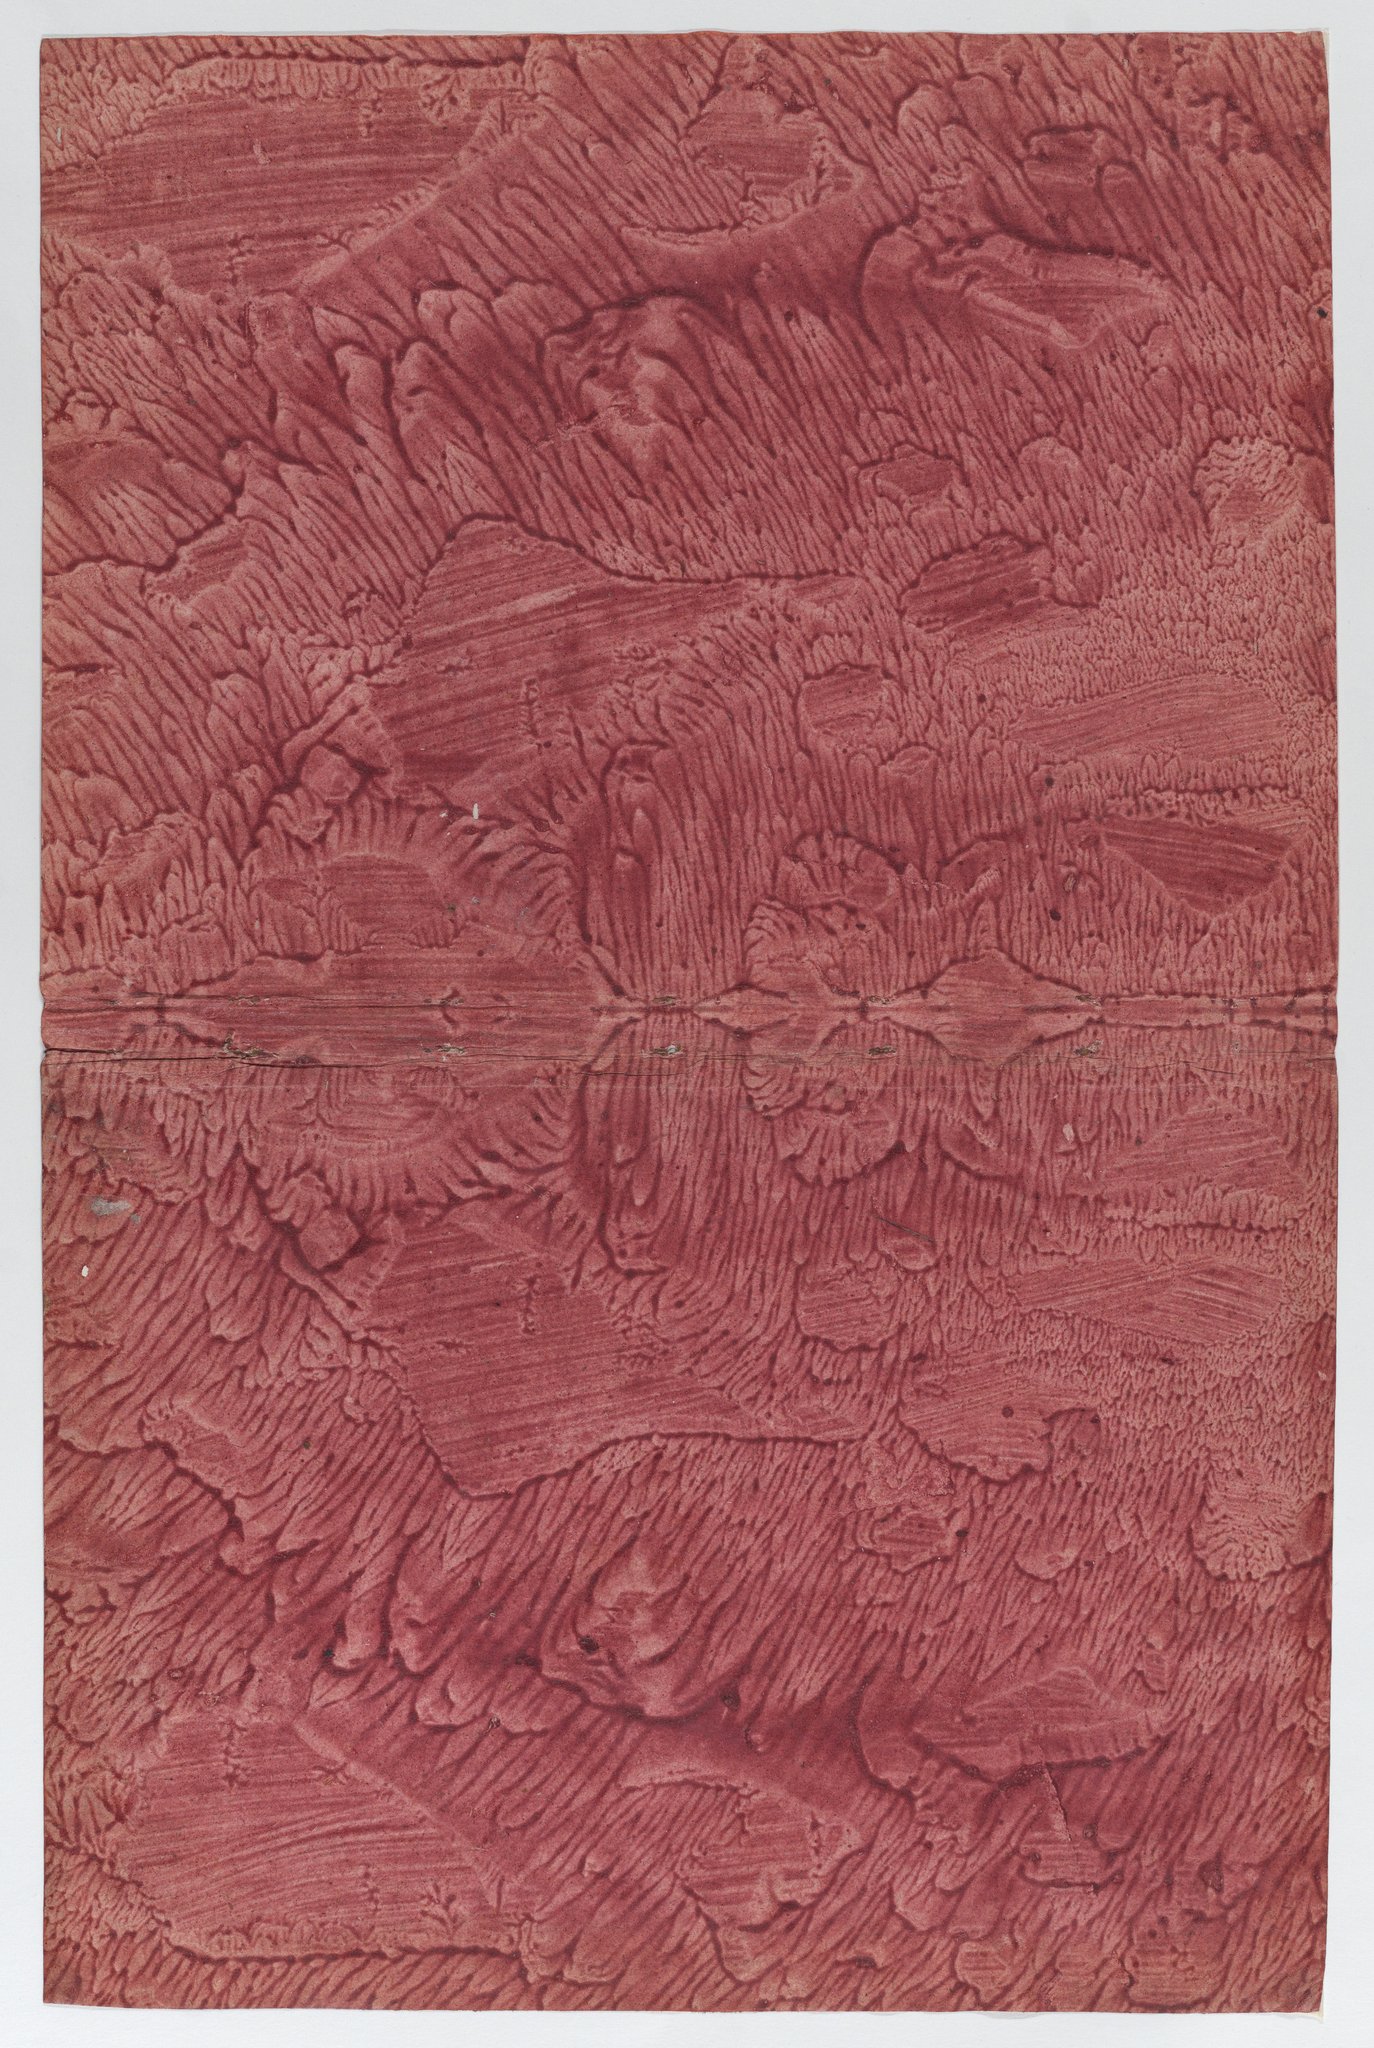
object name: print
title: Red paste paper book cover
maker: Anonymous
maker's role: artist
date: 1801-1900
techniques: relief print